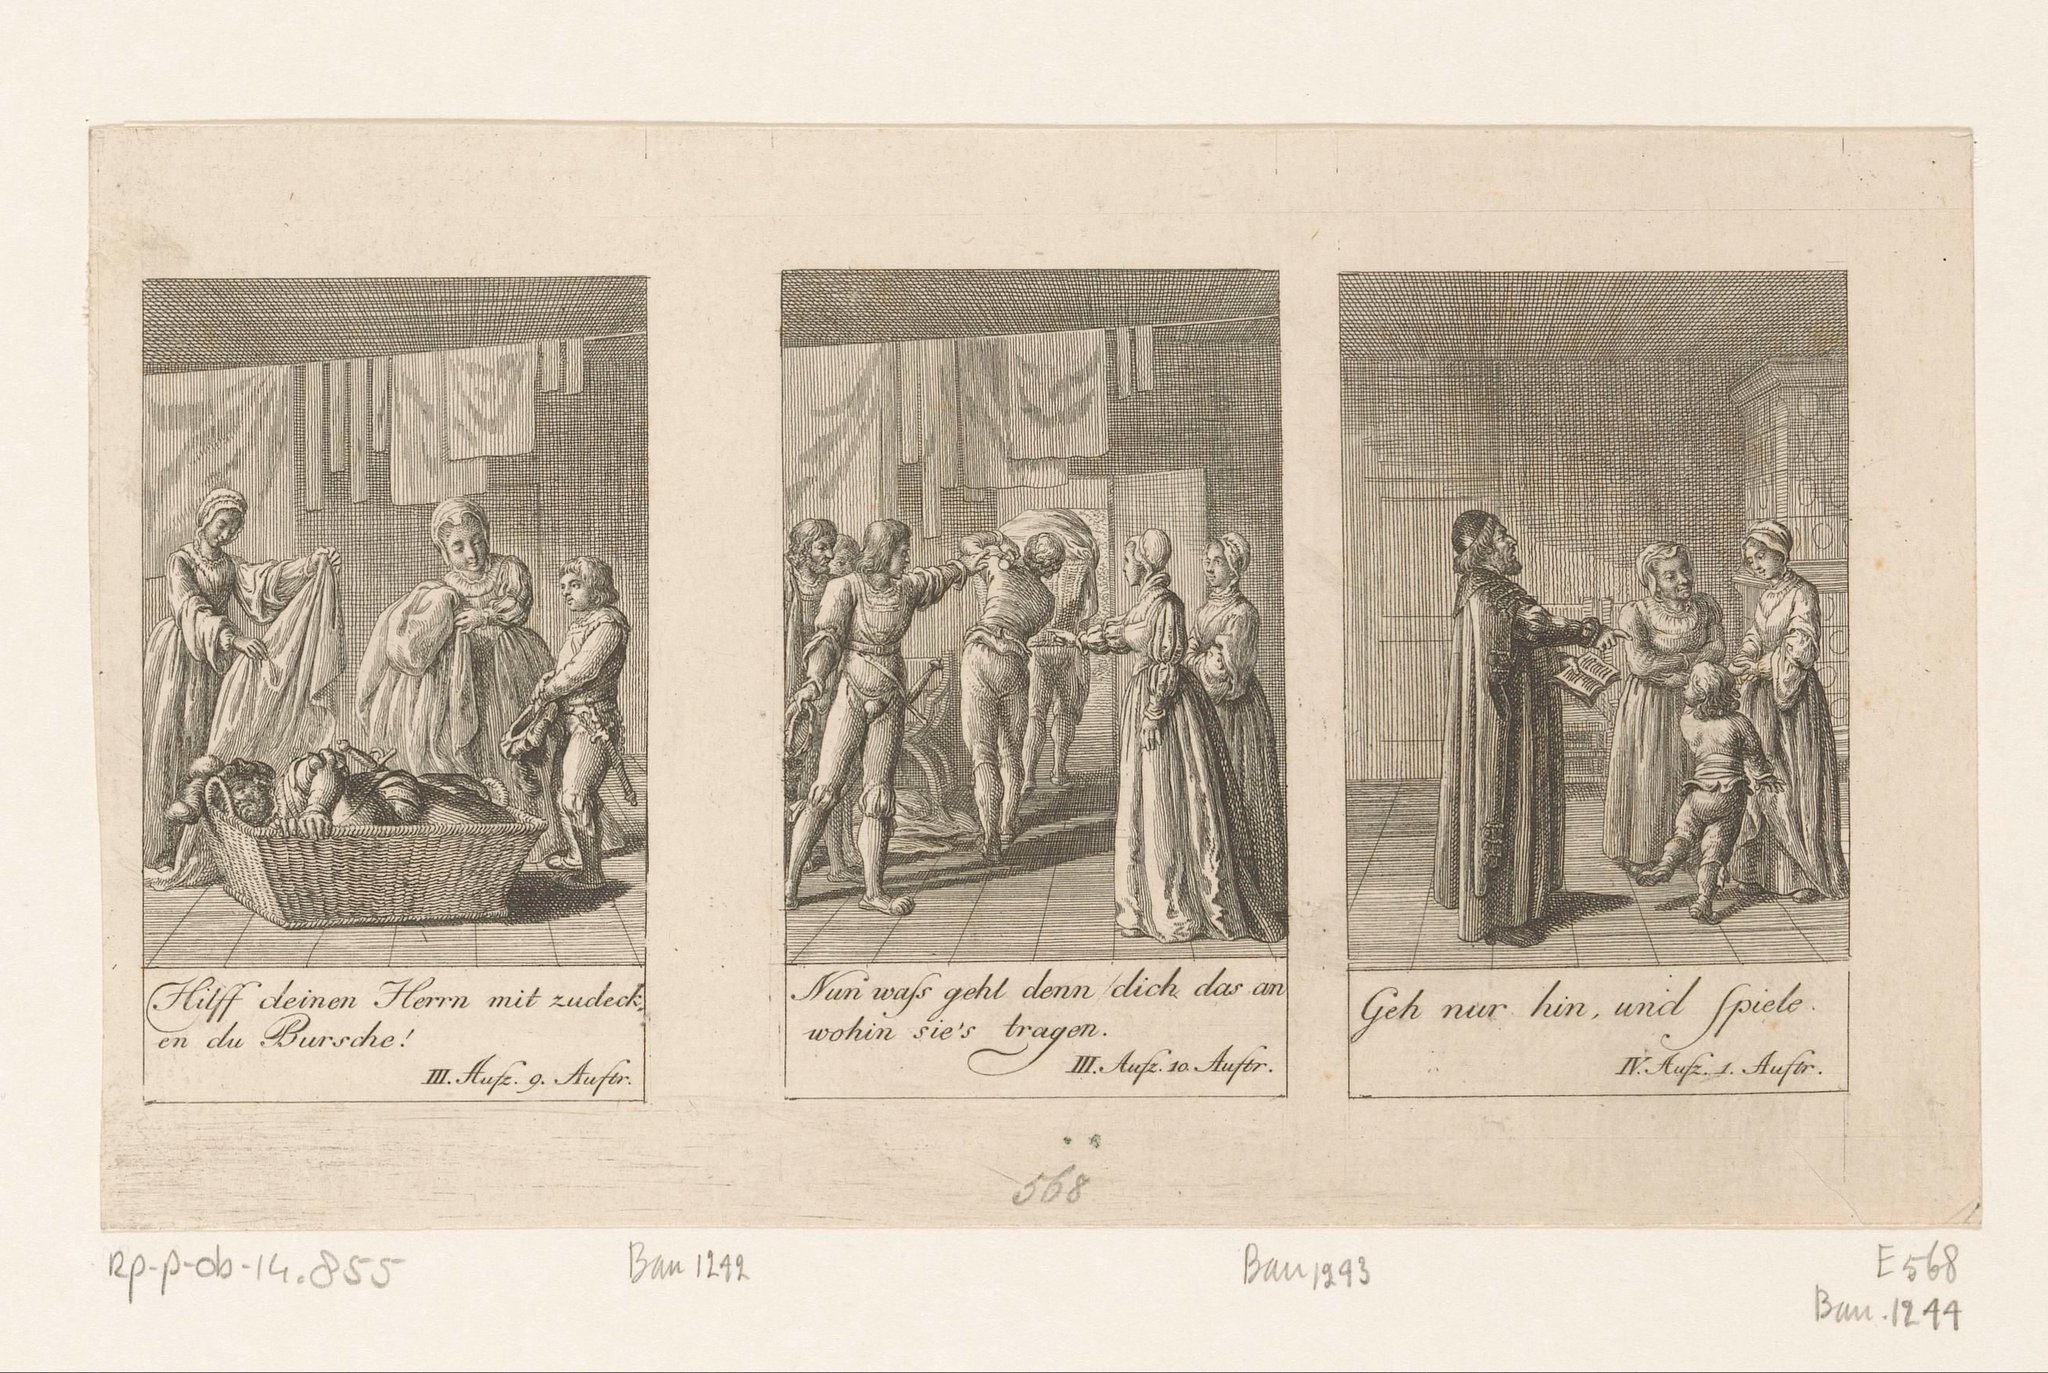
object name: print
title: Drie voorstellingen uit William Shakespeares Merry Wives of Windsor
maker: daniel nikolaus chodowiecki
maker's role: draughtsman, print maker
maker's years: 1726-1801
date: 1786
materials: paper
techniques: etching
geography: berlin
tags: william shakespeare, literature, teacher and pupil, laundering, hiding, hiding oneself, falstaff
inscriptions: collector's mark: Lugt 2228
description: Vervaardigd voor William Shakespeares 'The Merry Wives of Windsor'. Latere staat gebruikt voor: Goettinger Taschen Calender vom Jahr 1787. Göttingen: Johann Christoph Dietrich, 1786.